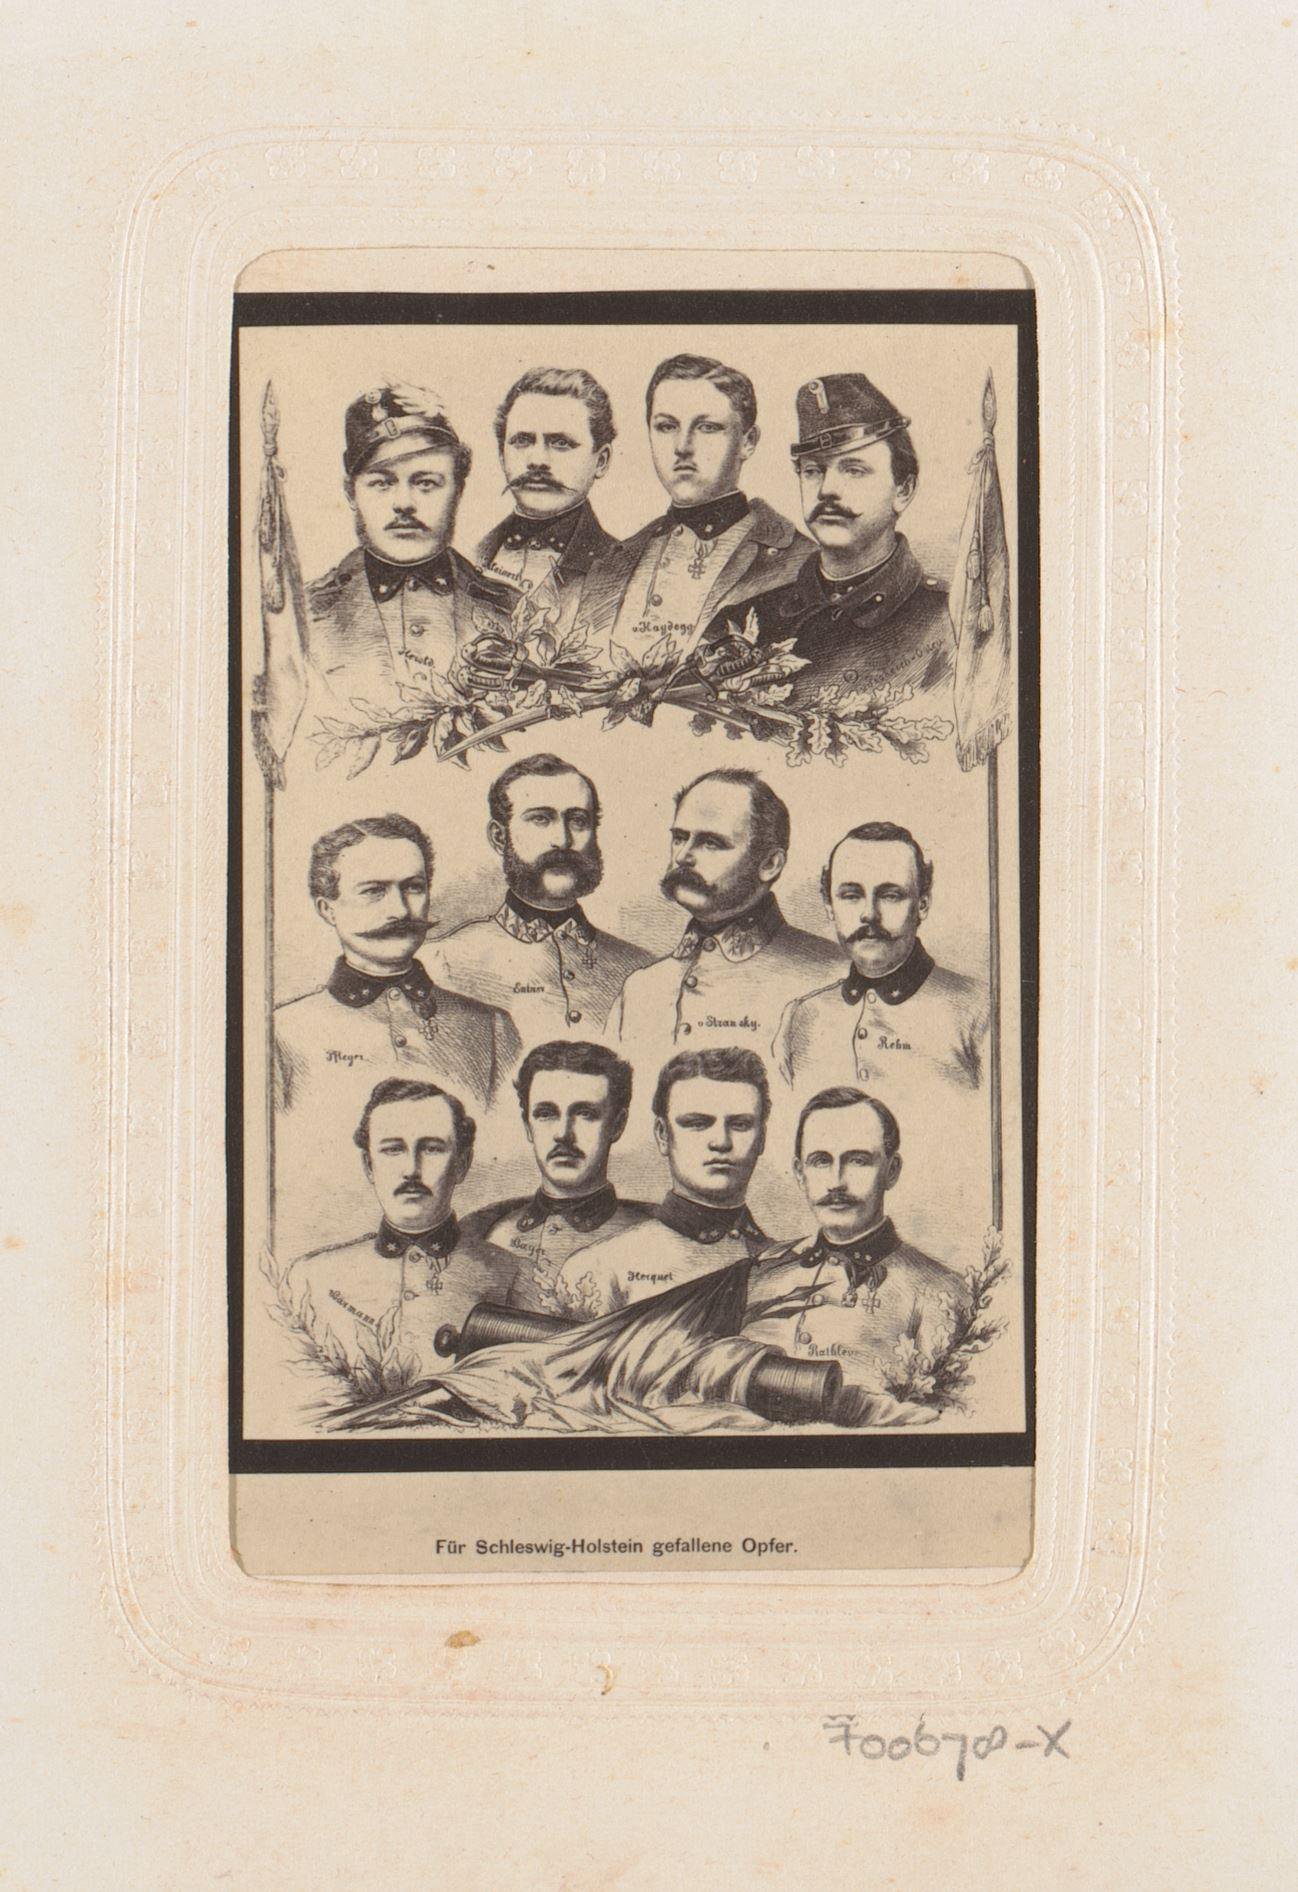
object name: reproduction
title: Fur Schleswig-Holstein gefallene opfer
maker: Anonymous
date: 1860-1880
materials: cardboard, photographic support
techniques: albumen print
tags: historical persons